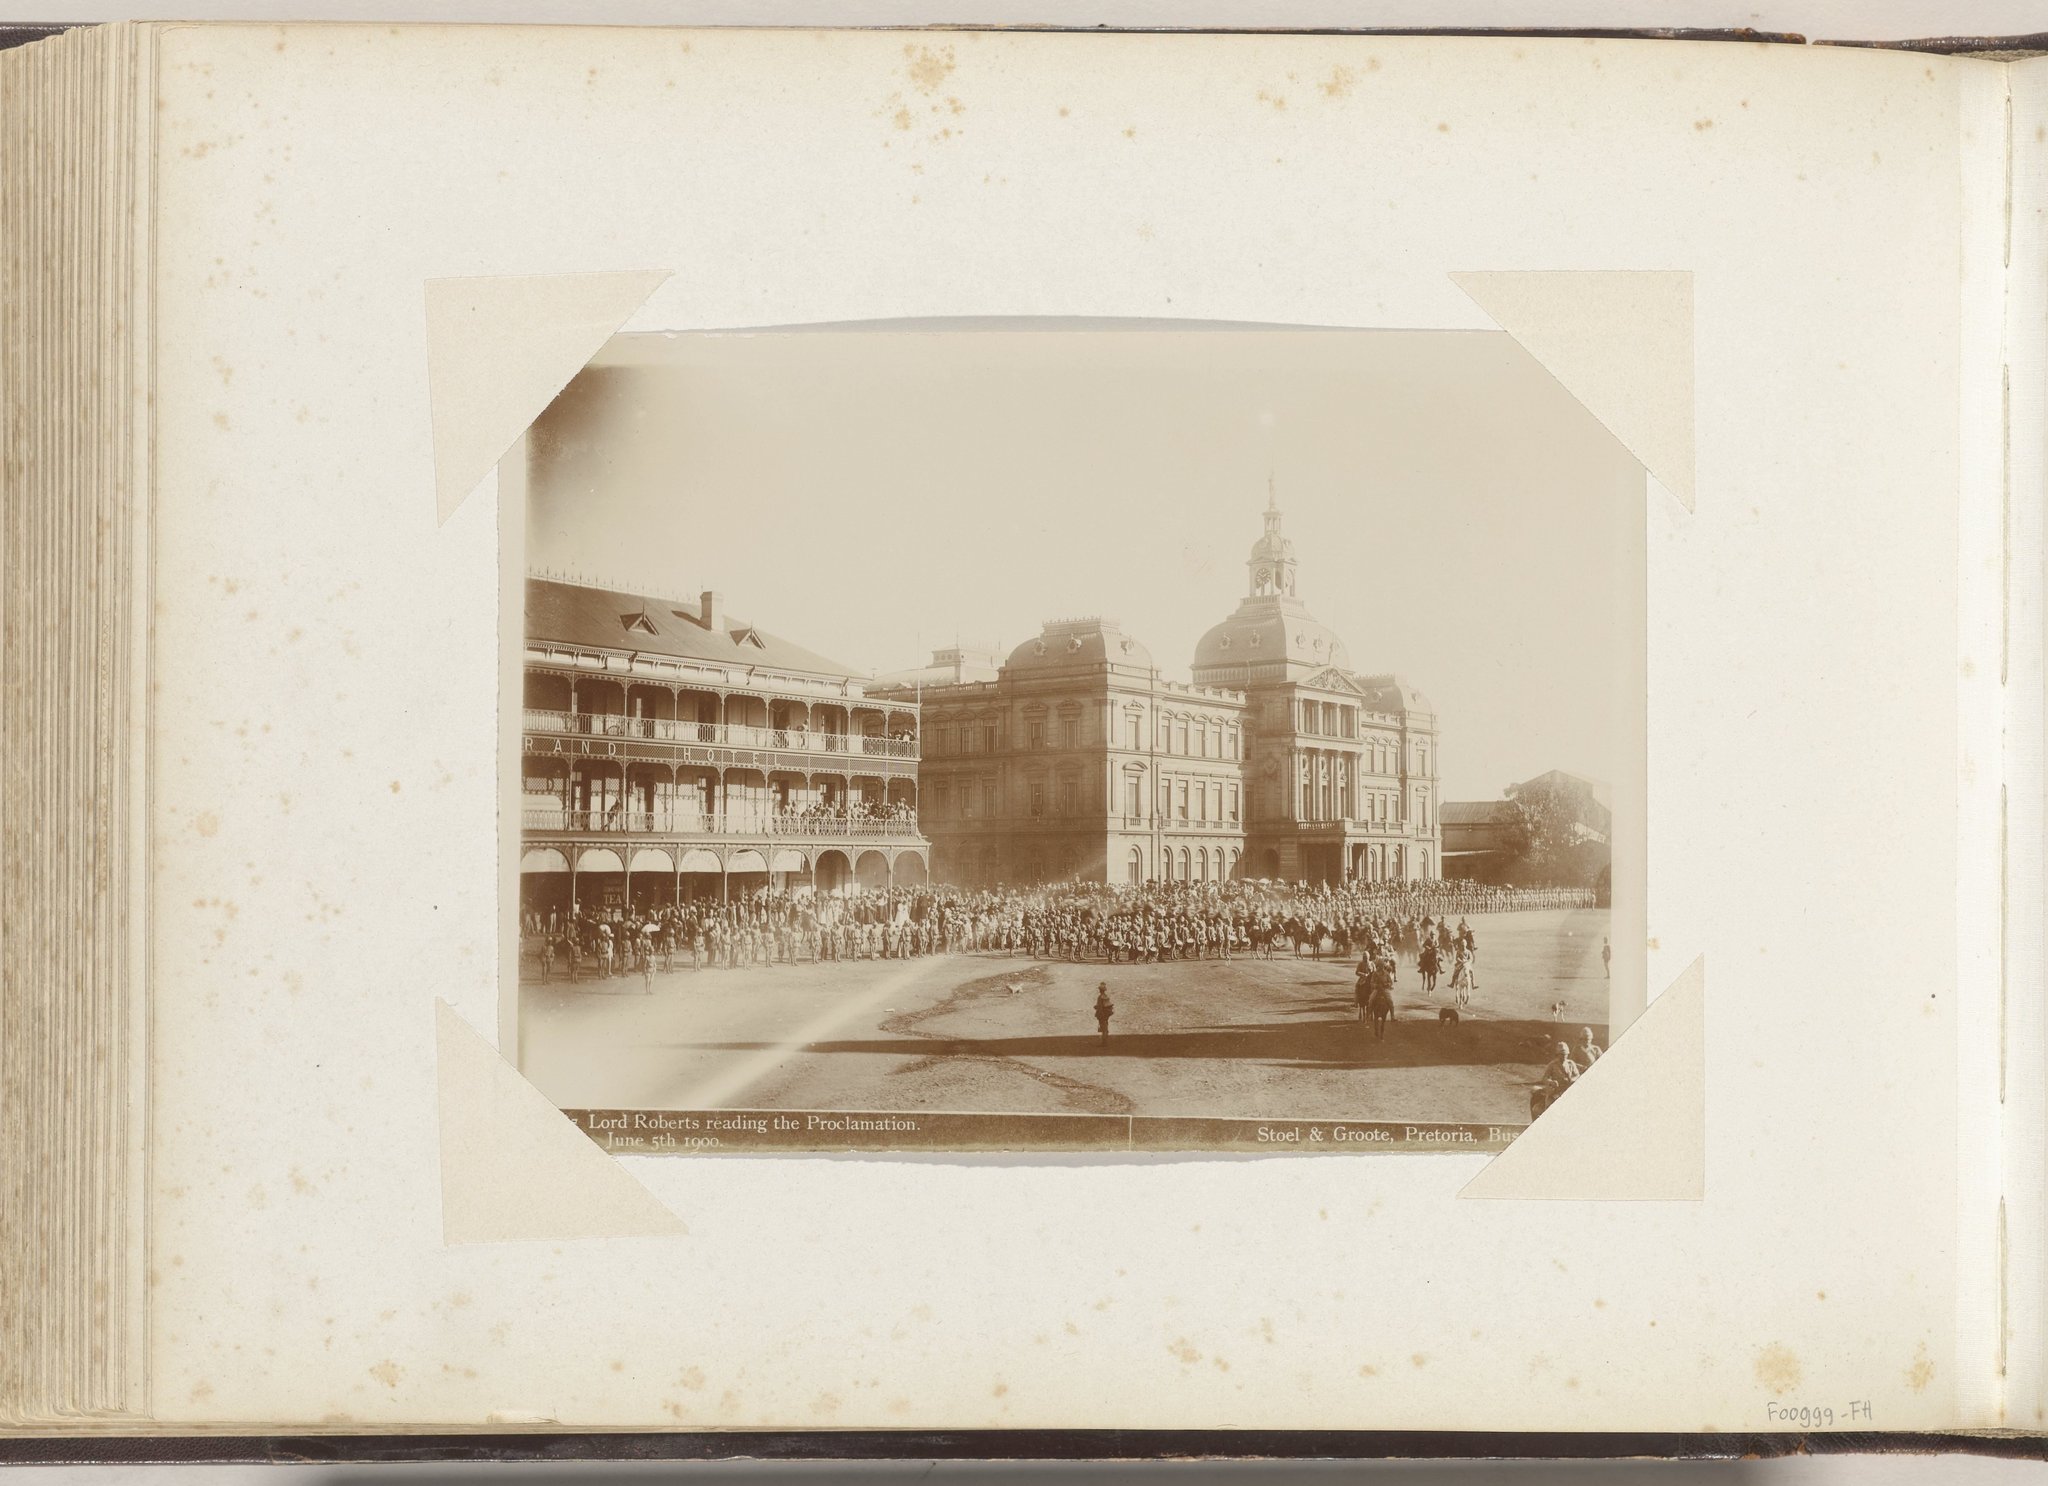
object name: photograph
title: Lord Roberts reading the Proclamation. June 5th 1900.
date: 1900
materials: paper, photographic support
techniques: gelatin silver print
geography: pretoria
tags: announcement, proclamation of laws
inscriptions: negative number: ‘no. 707 Pretoria, Bus 545’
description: Onderdeel van Album met 191 foto's van een reis naar en door Zuid-Afrika.